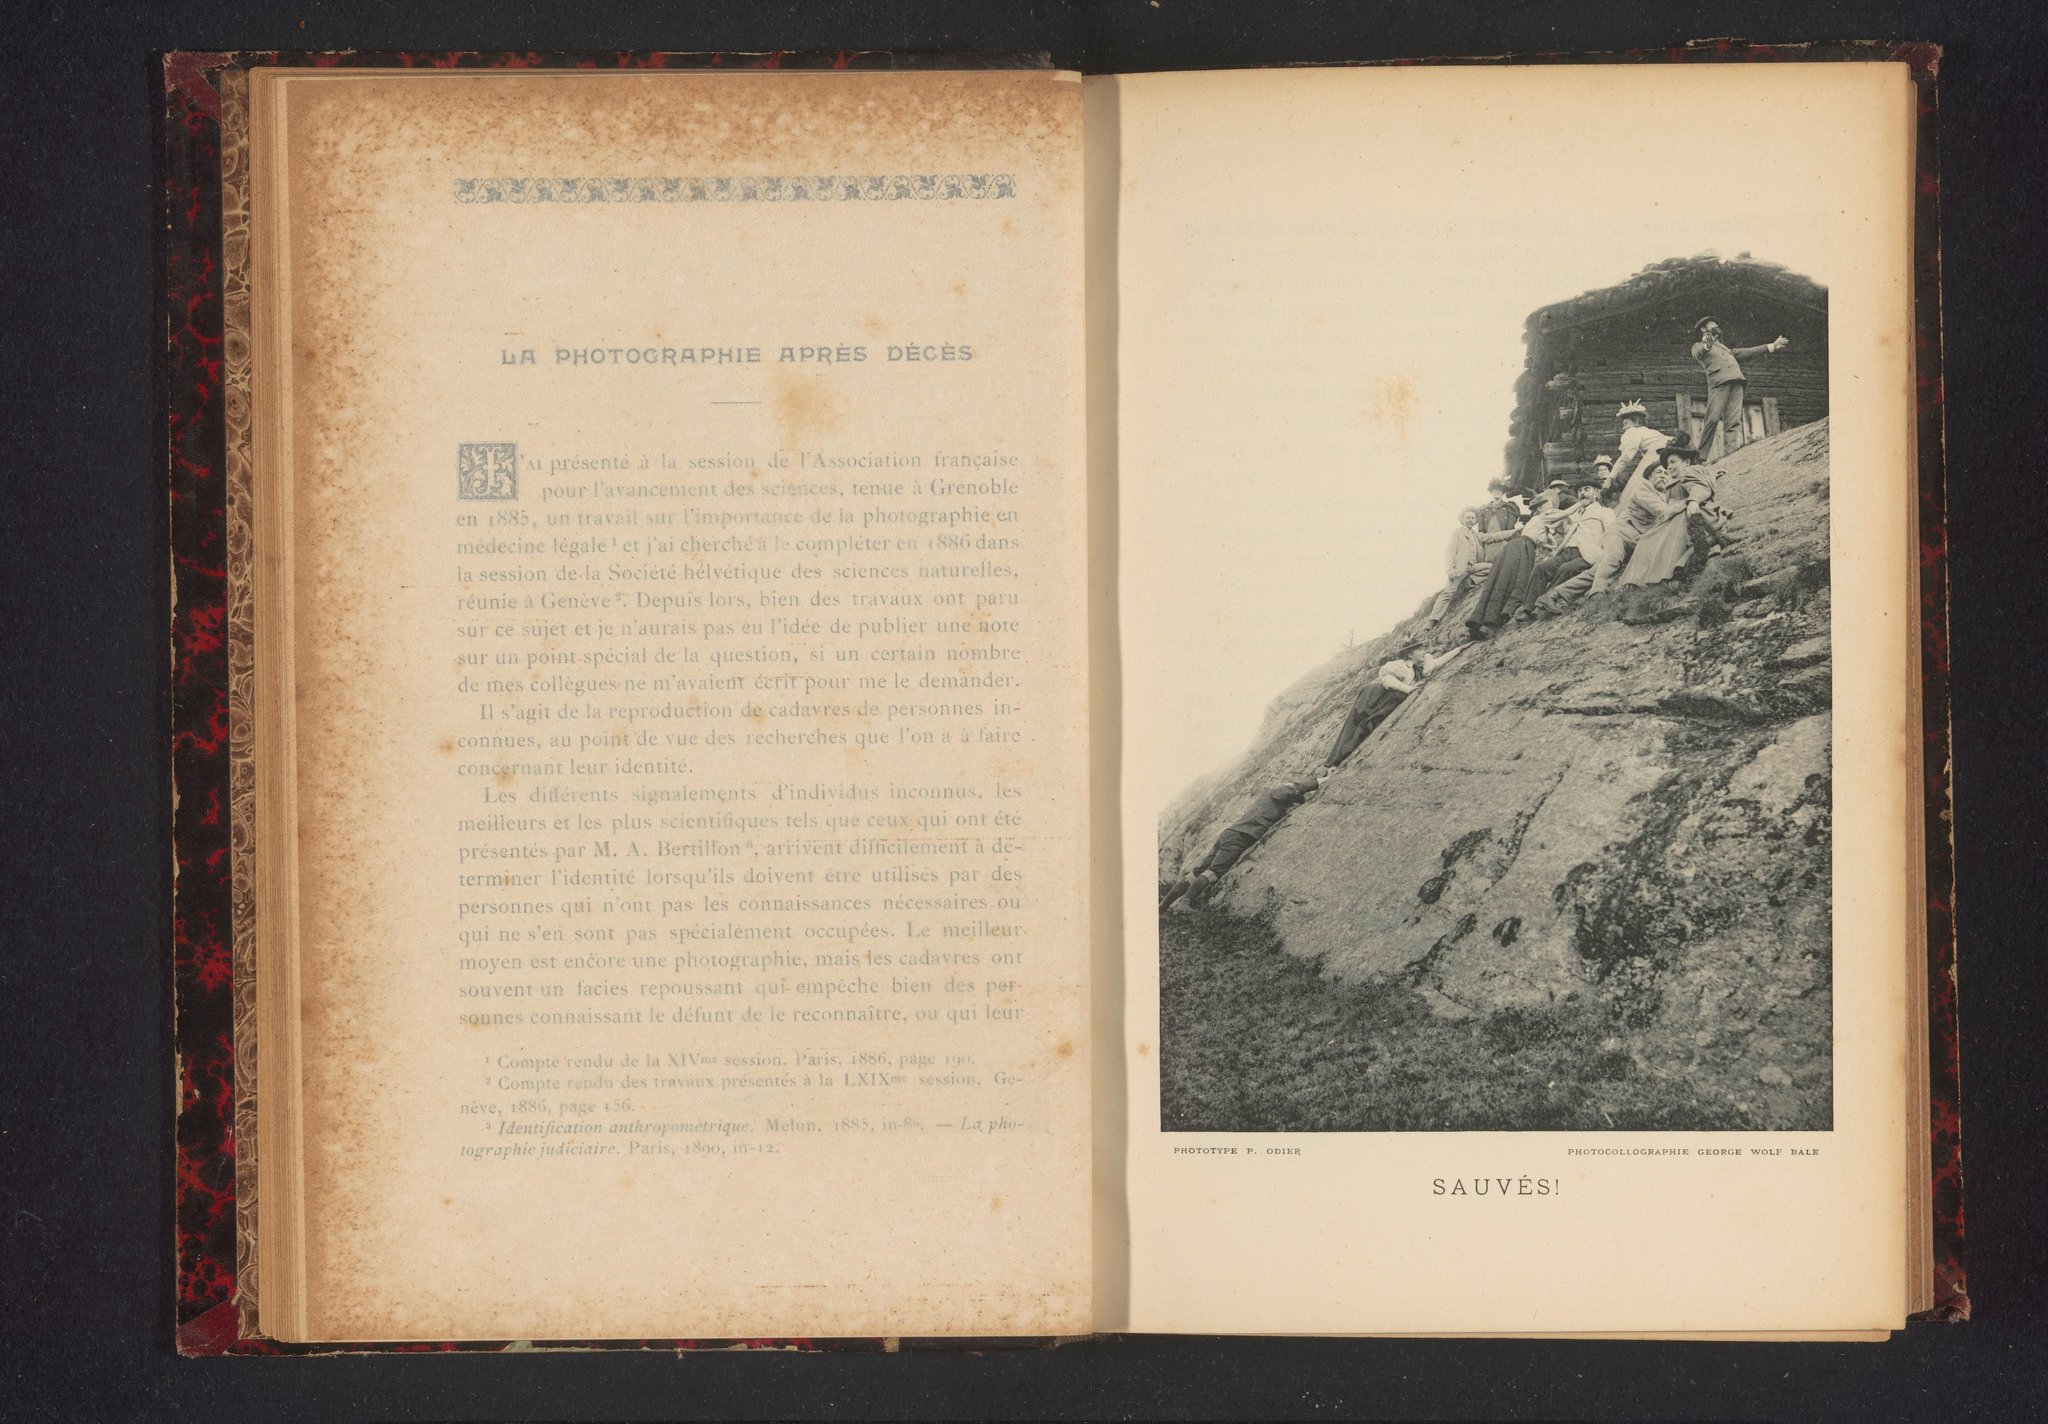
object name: photomechanical print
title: Sauvés!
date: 1892-1897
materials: paper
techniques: autotype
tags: adult woman, adult man, rock-formations